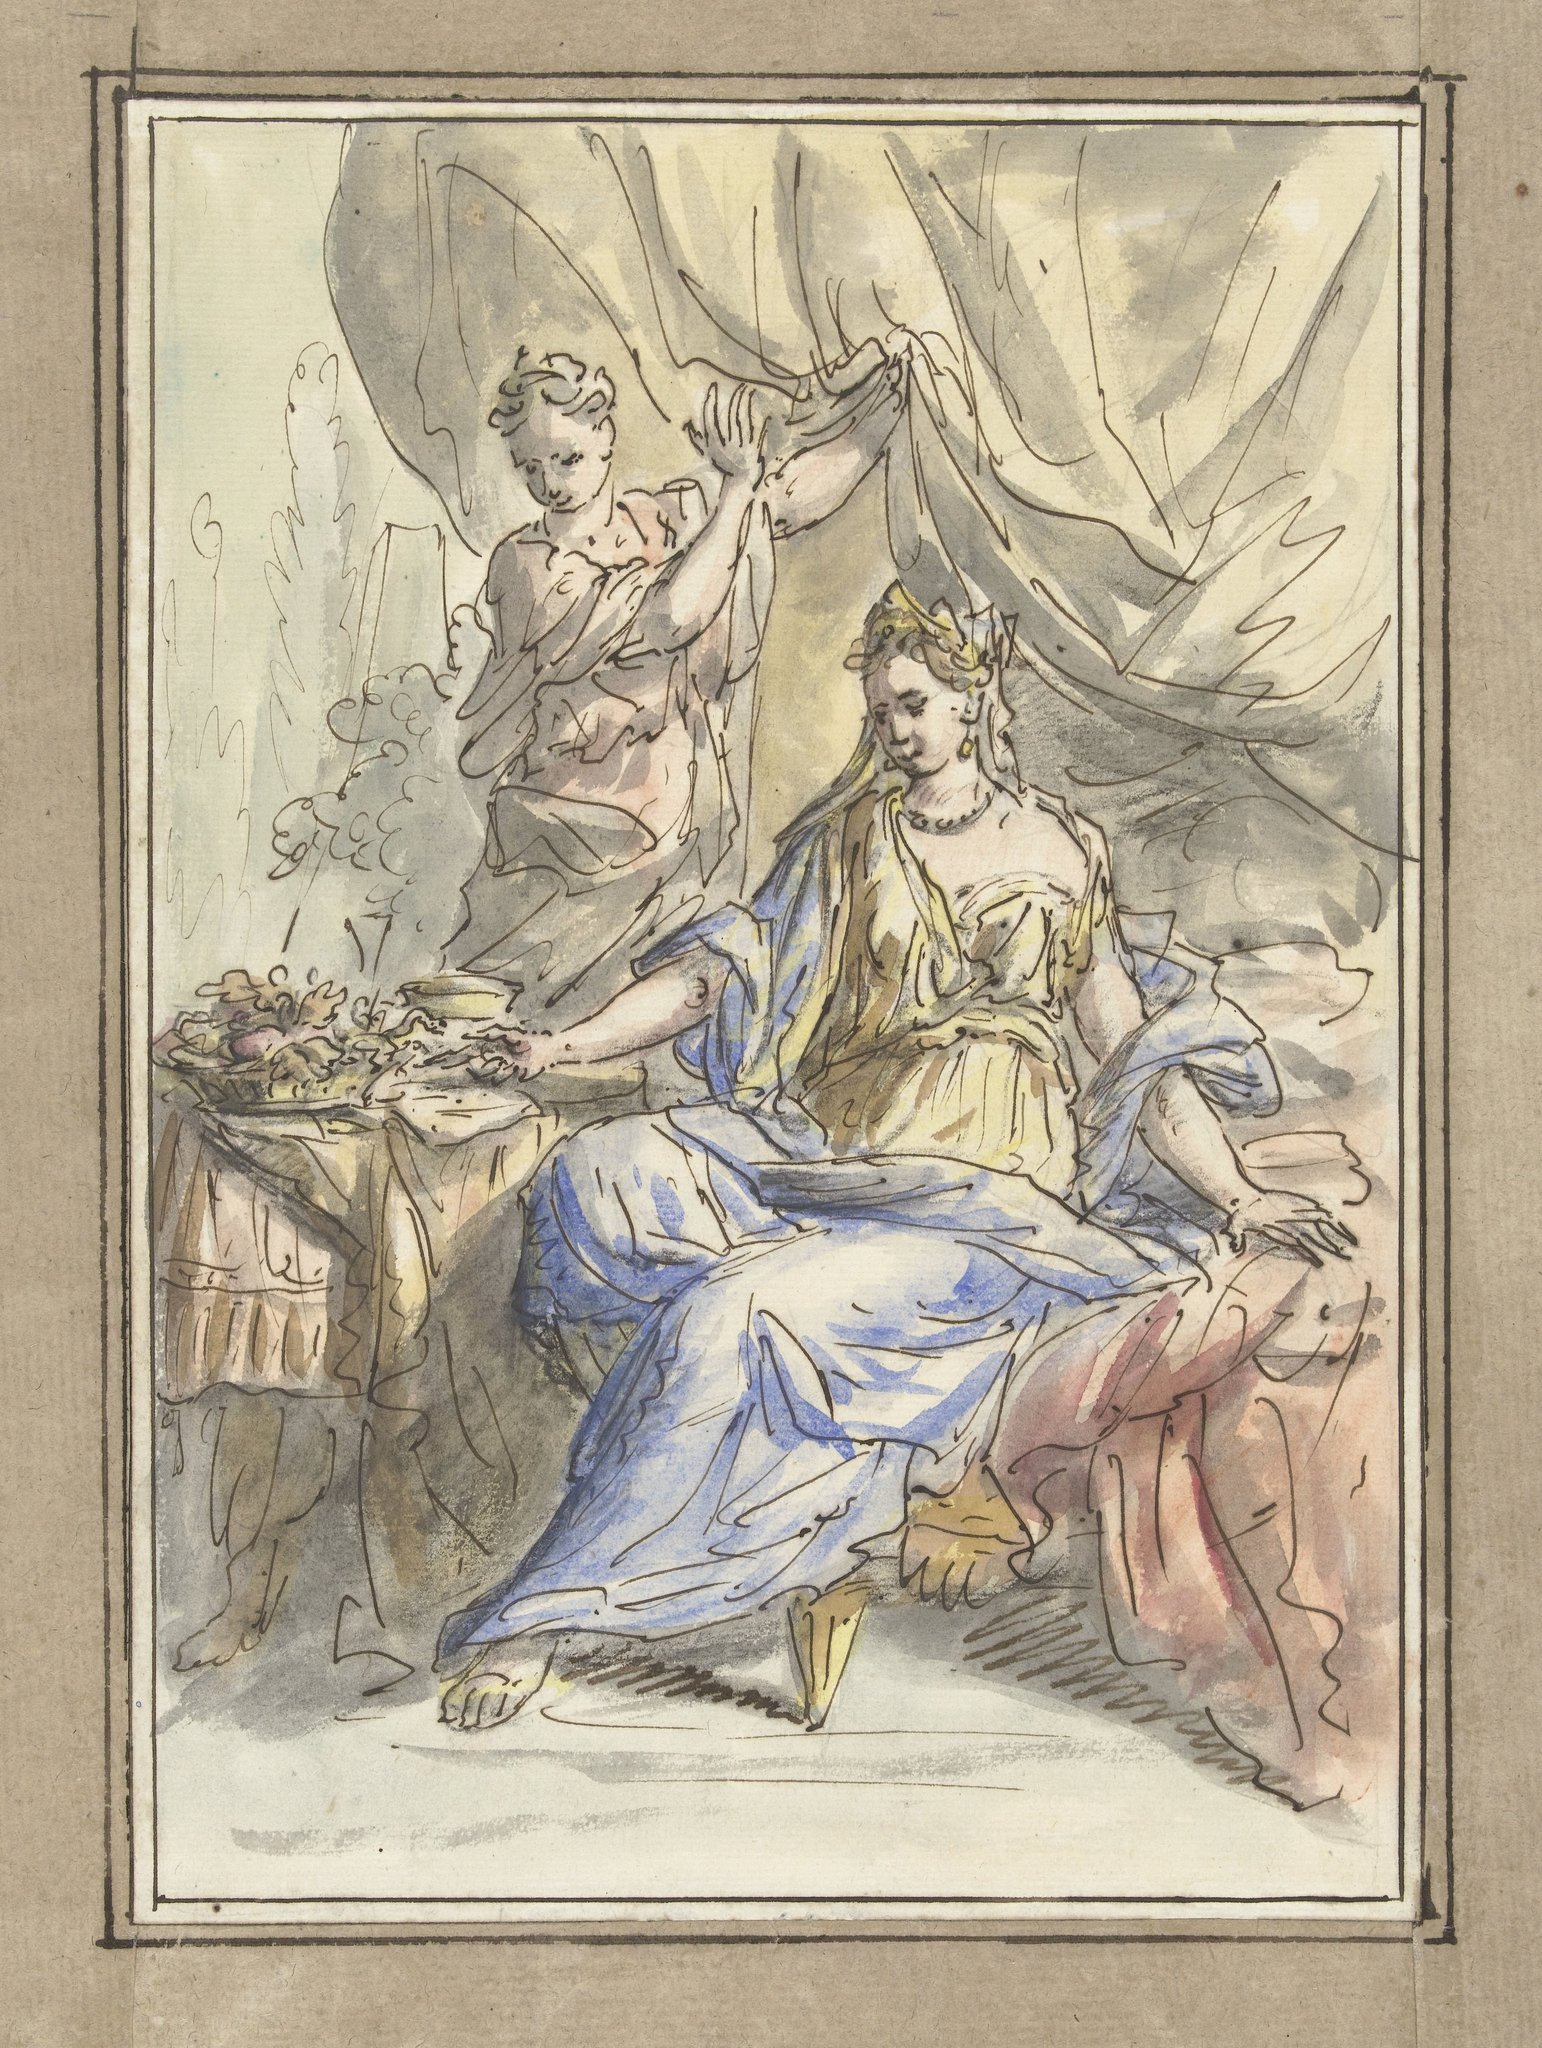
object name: design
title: Cleopatra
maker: elias van nijmegen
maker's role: draughtsman, painter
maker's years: 1667-1755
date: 1677-1755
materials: chalk, ink, paper, pencil, watercolor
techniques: brush, pen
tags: male persons from classical history (cleopatra)